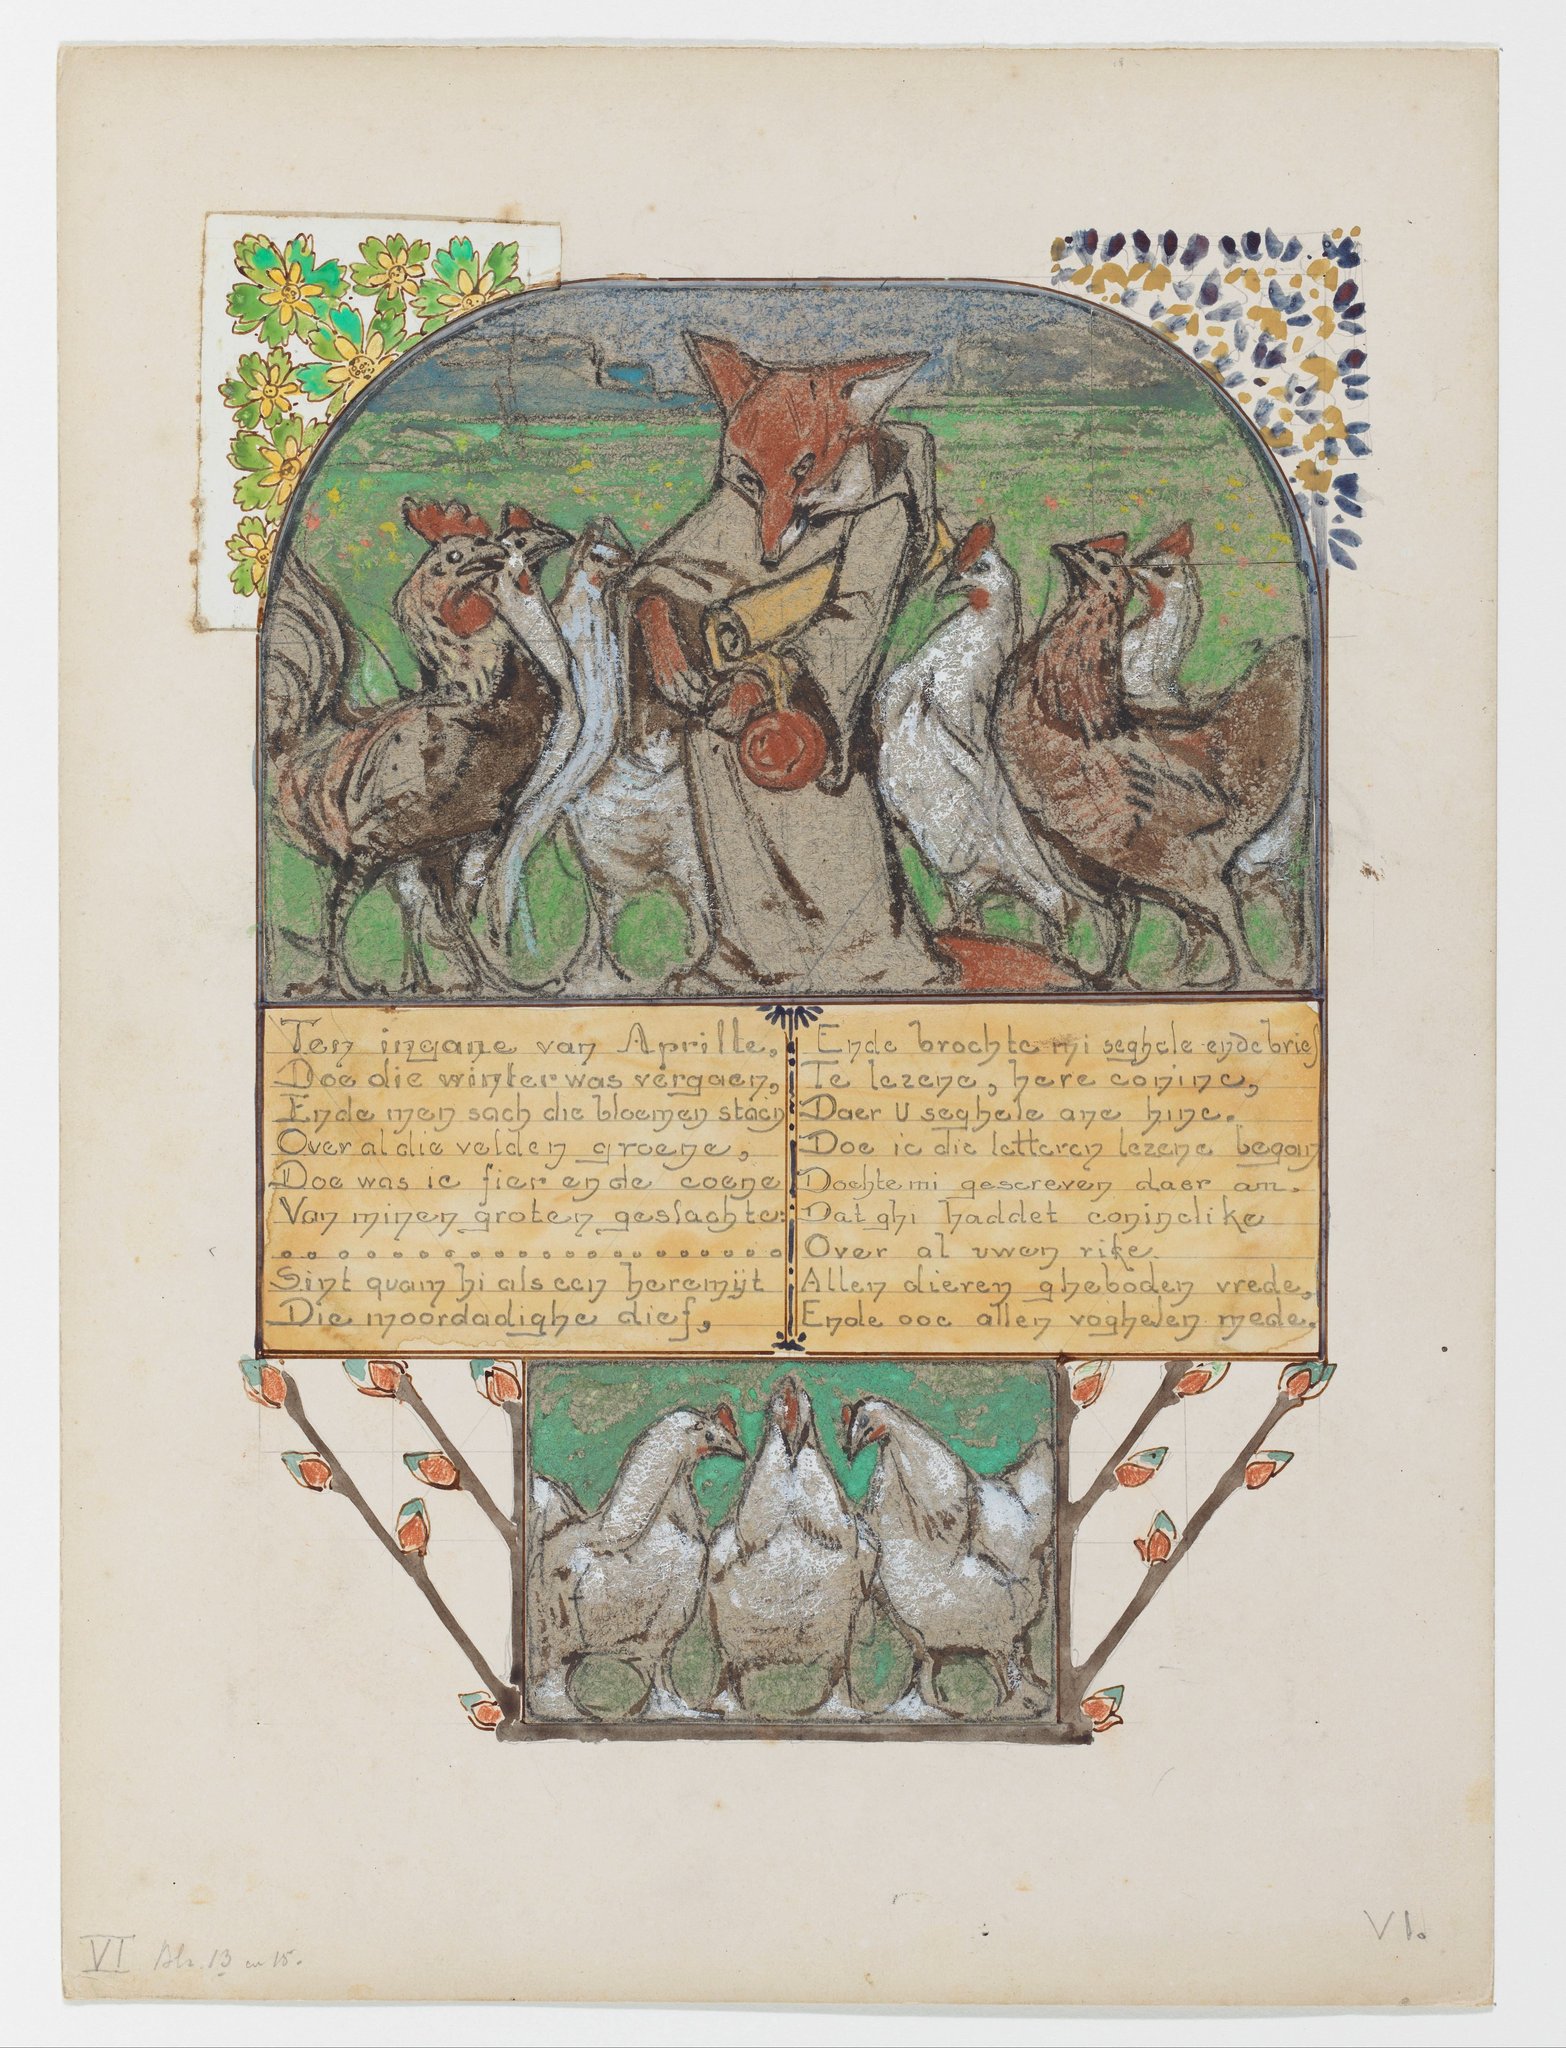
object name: design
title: Reinaert met een brief bij Canteclaer en zijn gezin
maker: bernard willem wierink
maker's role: draughtsman, print maker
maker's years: 1856-1939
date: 1866-1939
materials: cardboard, chalk, ink, paper, pencil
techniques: brush, pen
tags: fable of reynard the fox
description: Ontwerp voor illustratie (fol. 6, eerste ontwerp): Van den Vos Reinaerde; Reinaert, als kluizenaar, met een brief bij Canteclaer en zijn gezin, in een landschap.